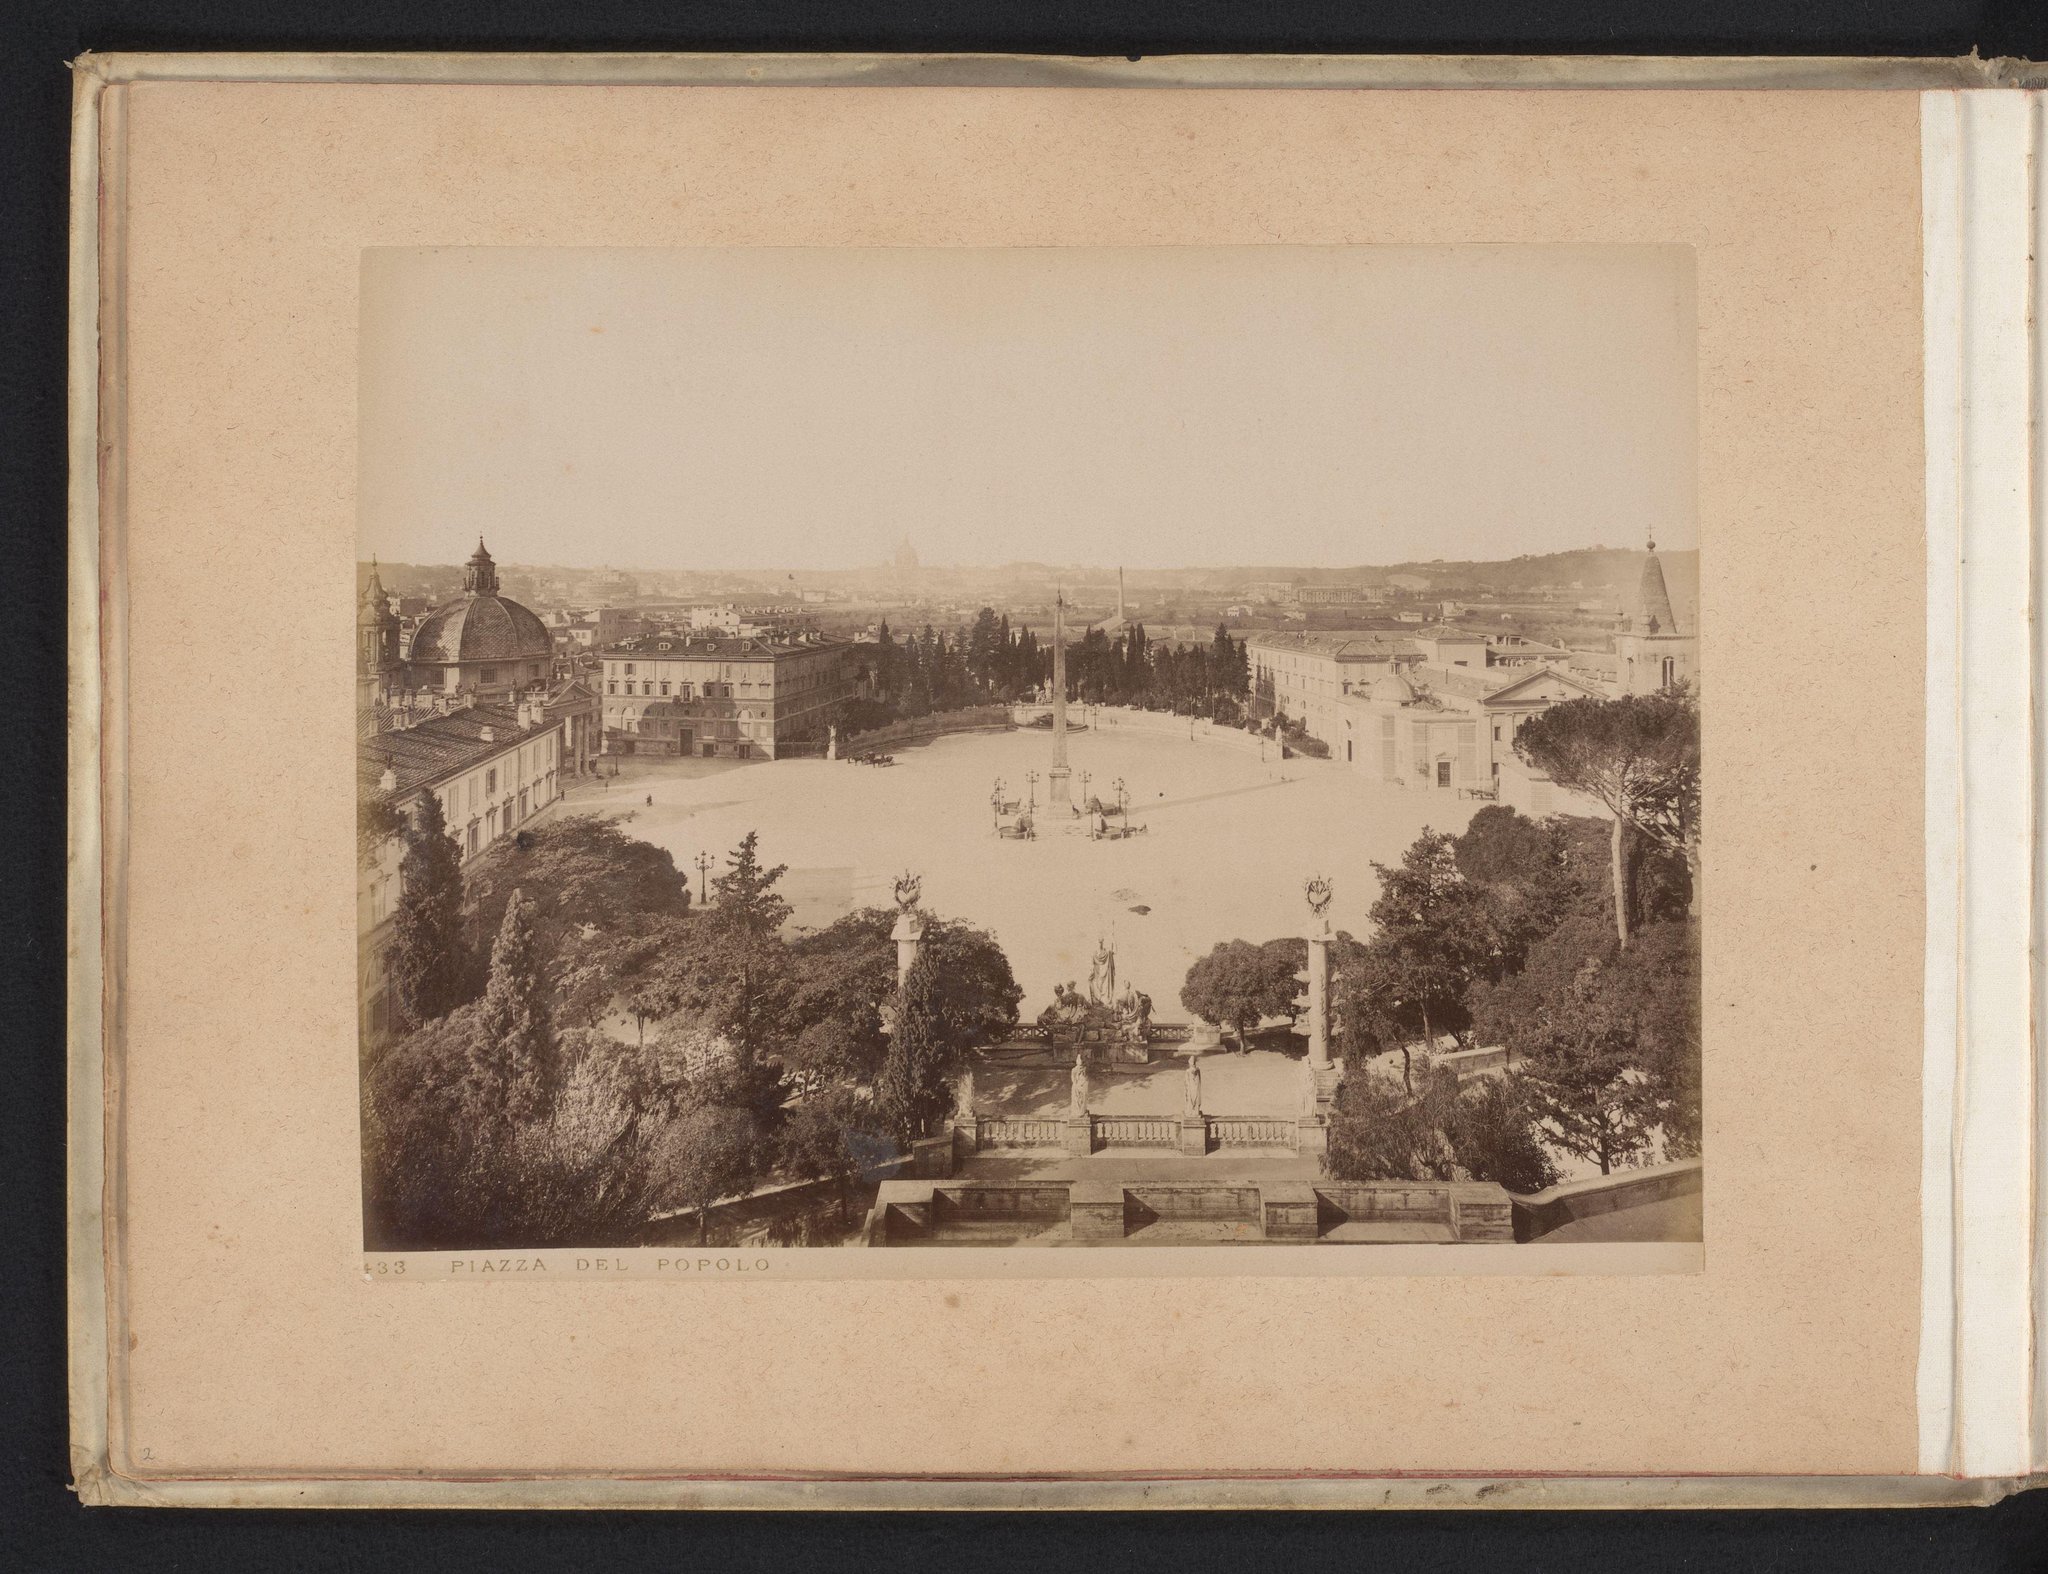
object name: photograph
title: Gezicht op Piazza del Popolo in Rome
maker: Anonymous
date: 1870-1895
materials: cardboard, photographic support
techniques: albumen print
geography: rome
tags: square, place, circus, etc., prospect of city, town panorama, silhouette of city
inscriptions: inscription: ‘433 PIAZZA DEL POPOLO’